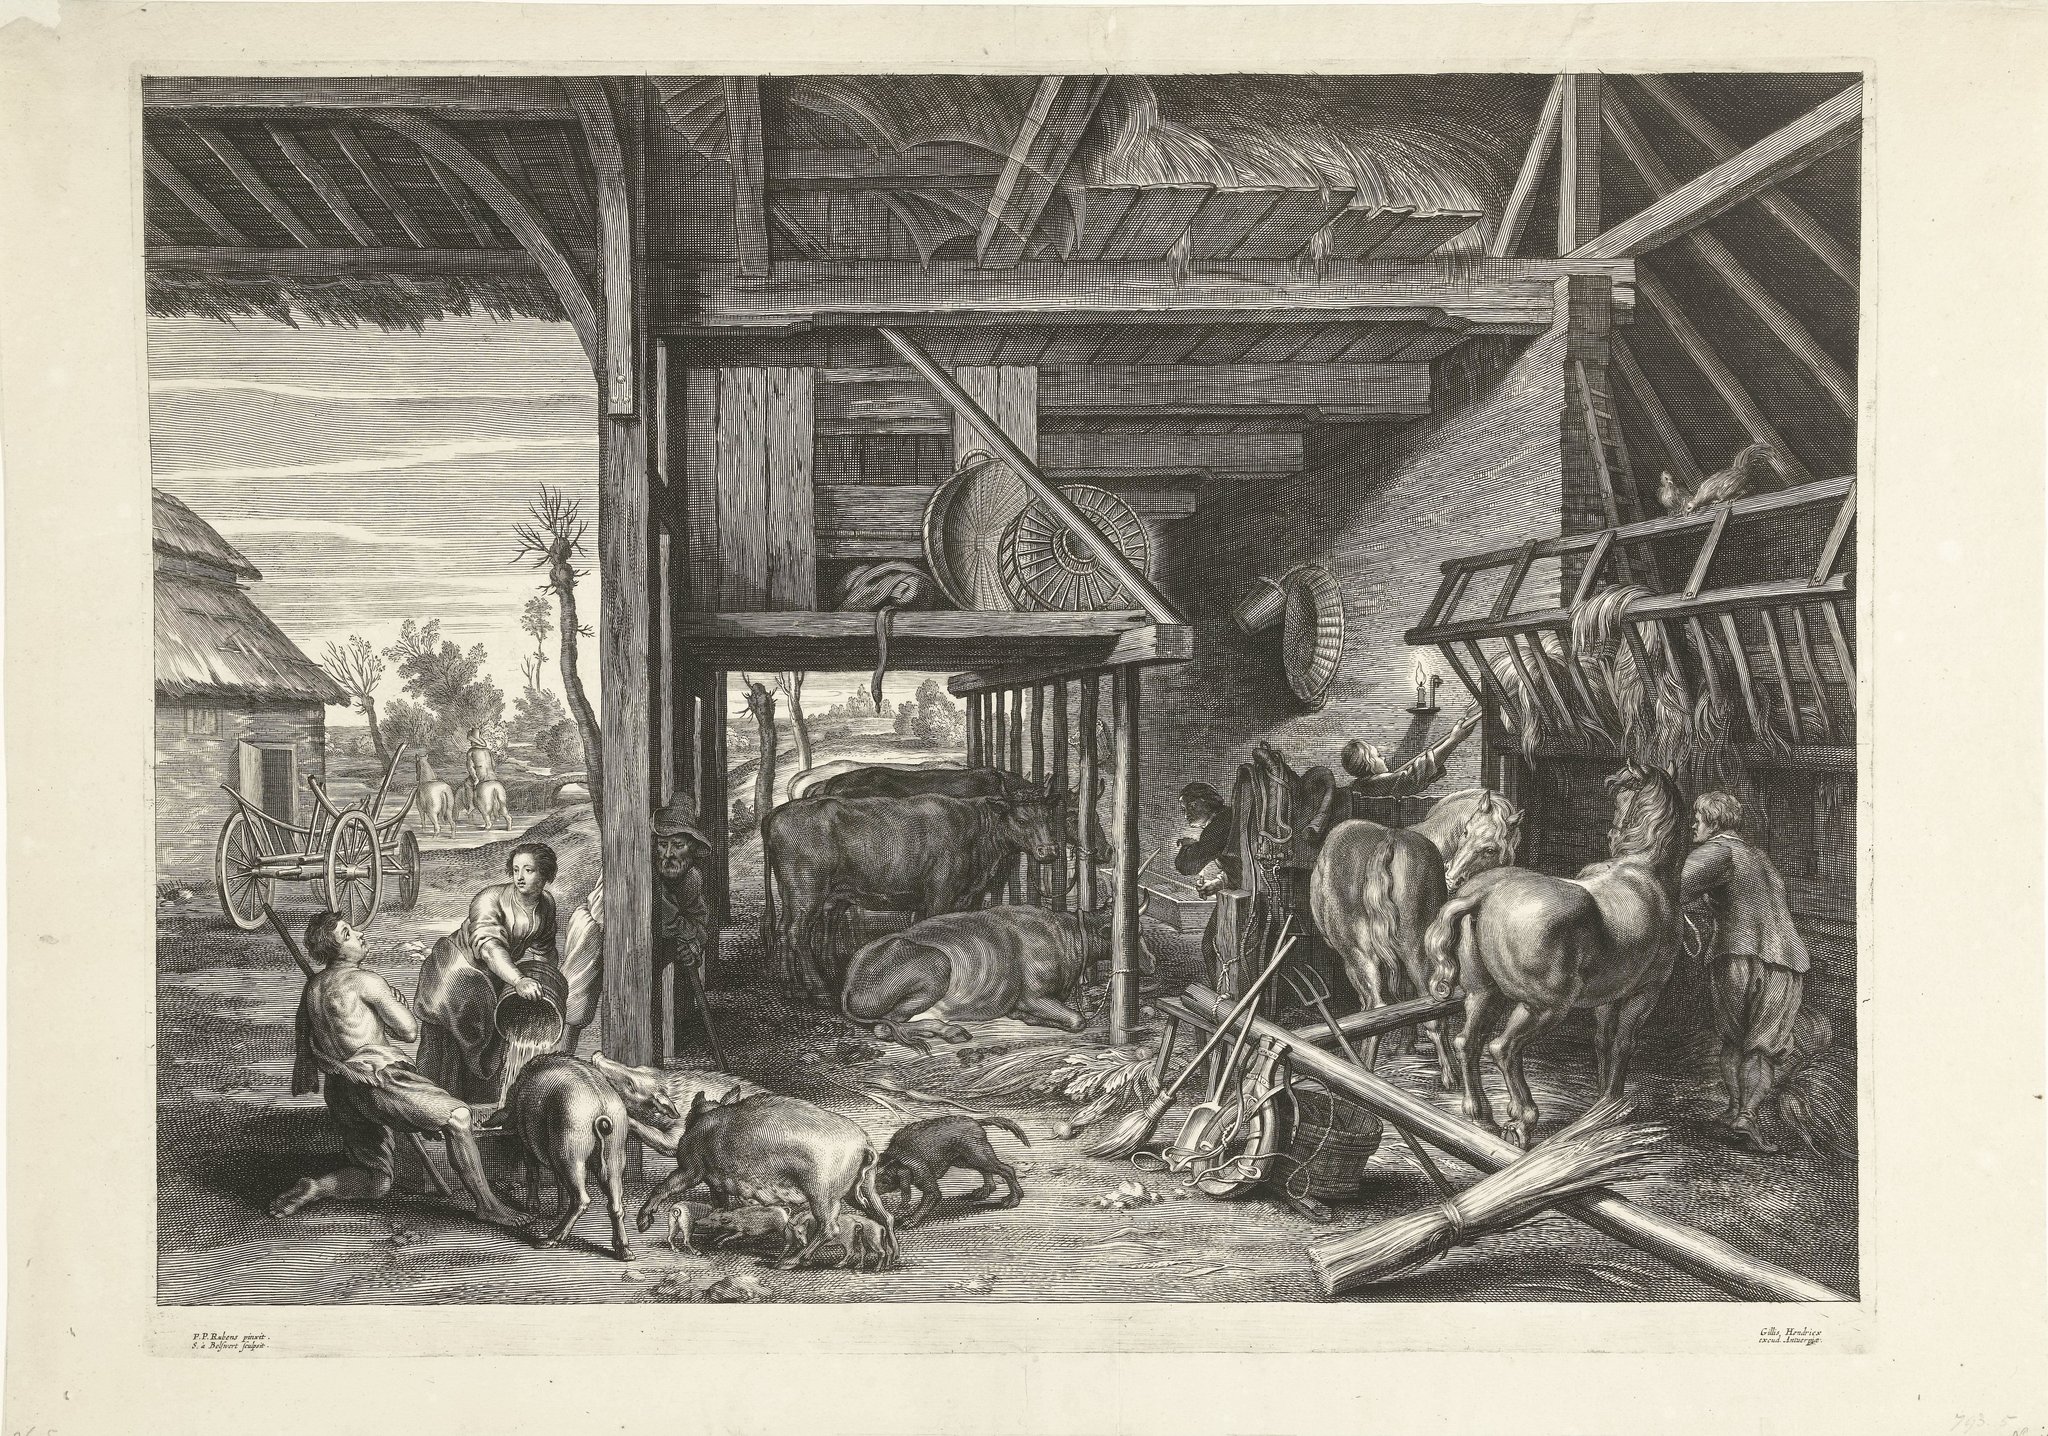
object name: print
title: Landschappen met bijbelse en mythologische scènes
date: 1618-1659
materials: paper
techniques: engraving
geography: antwerp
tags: barn - aa - civic architecture: inside, the prodigal son tends the swine and eats from their trough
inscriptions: collector's mark: Lugt 240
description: De verloren zoon als varkenshoeder. In een stal eet de verloren zoon met de varkens uit de voederbak. In de stal zijn andere knechten bezig de koeien en paarden te verzorgen. Een dienstmaagd giet het varkensvoer in de bak.